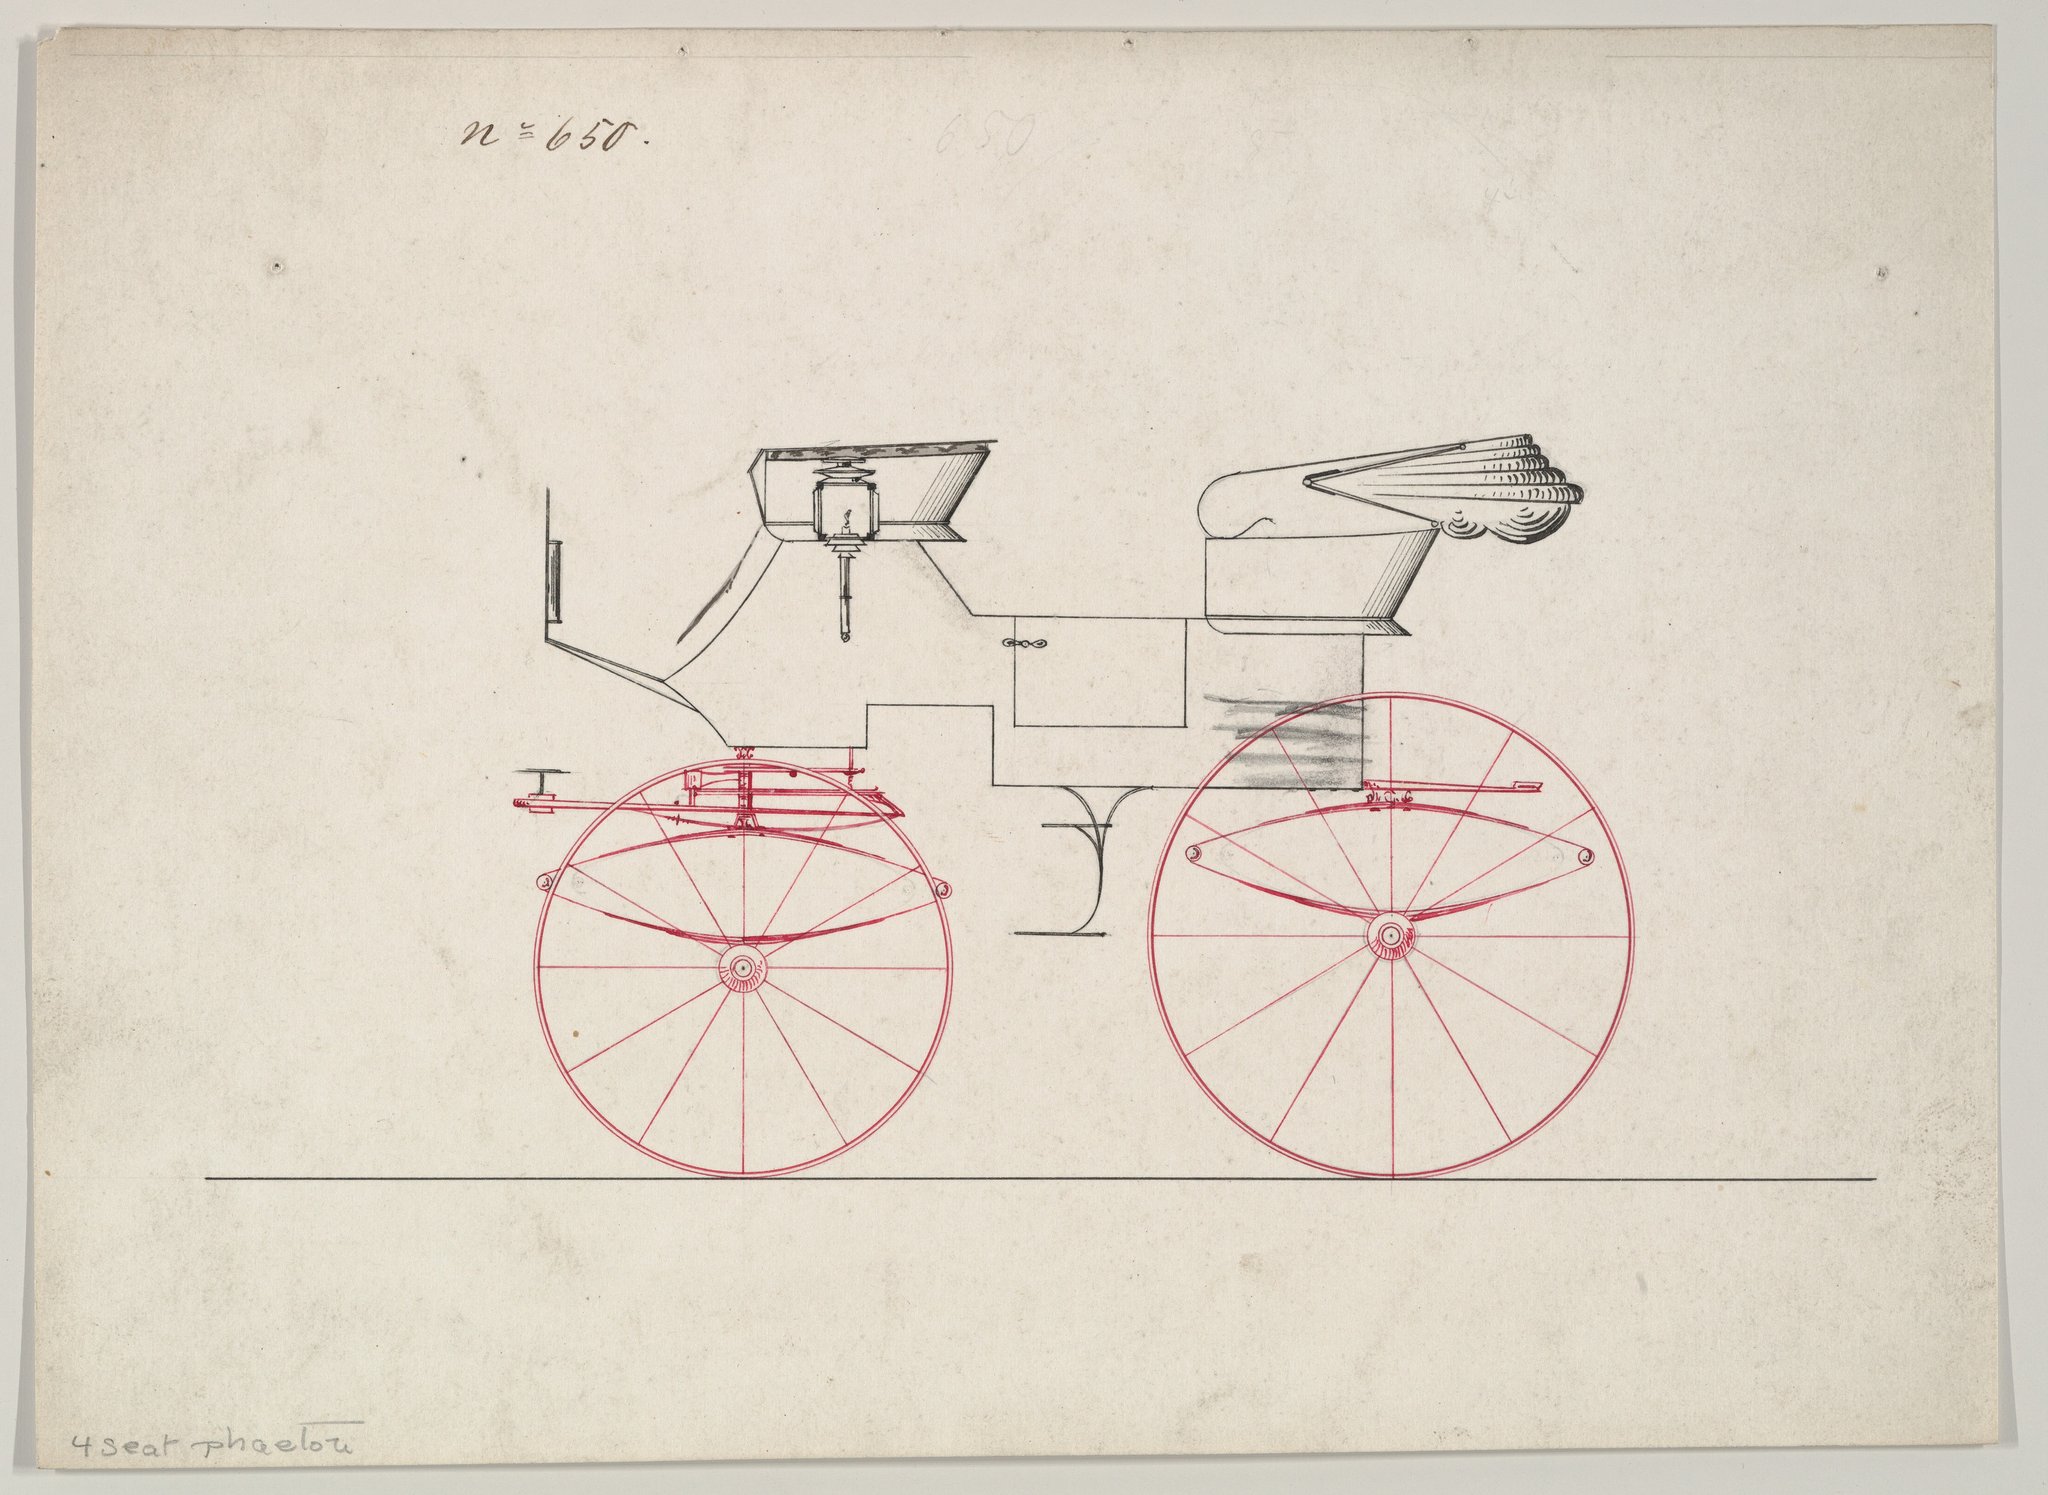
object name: drawing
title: Design for Phaeton, no. 650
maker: brewster & co.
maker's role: manufacturer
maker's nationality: american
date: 1850-1874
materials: graphite, ink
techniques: pen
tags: carriages